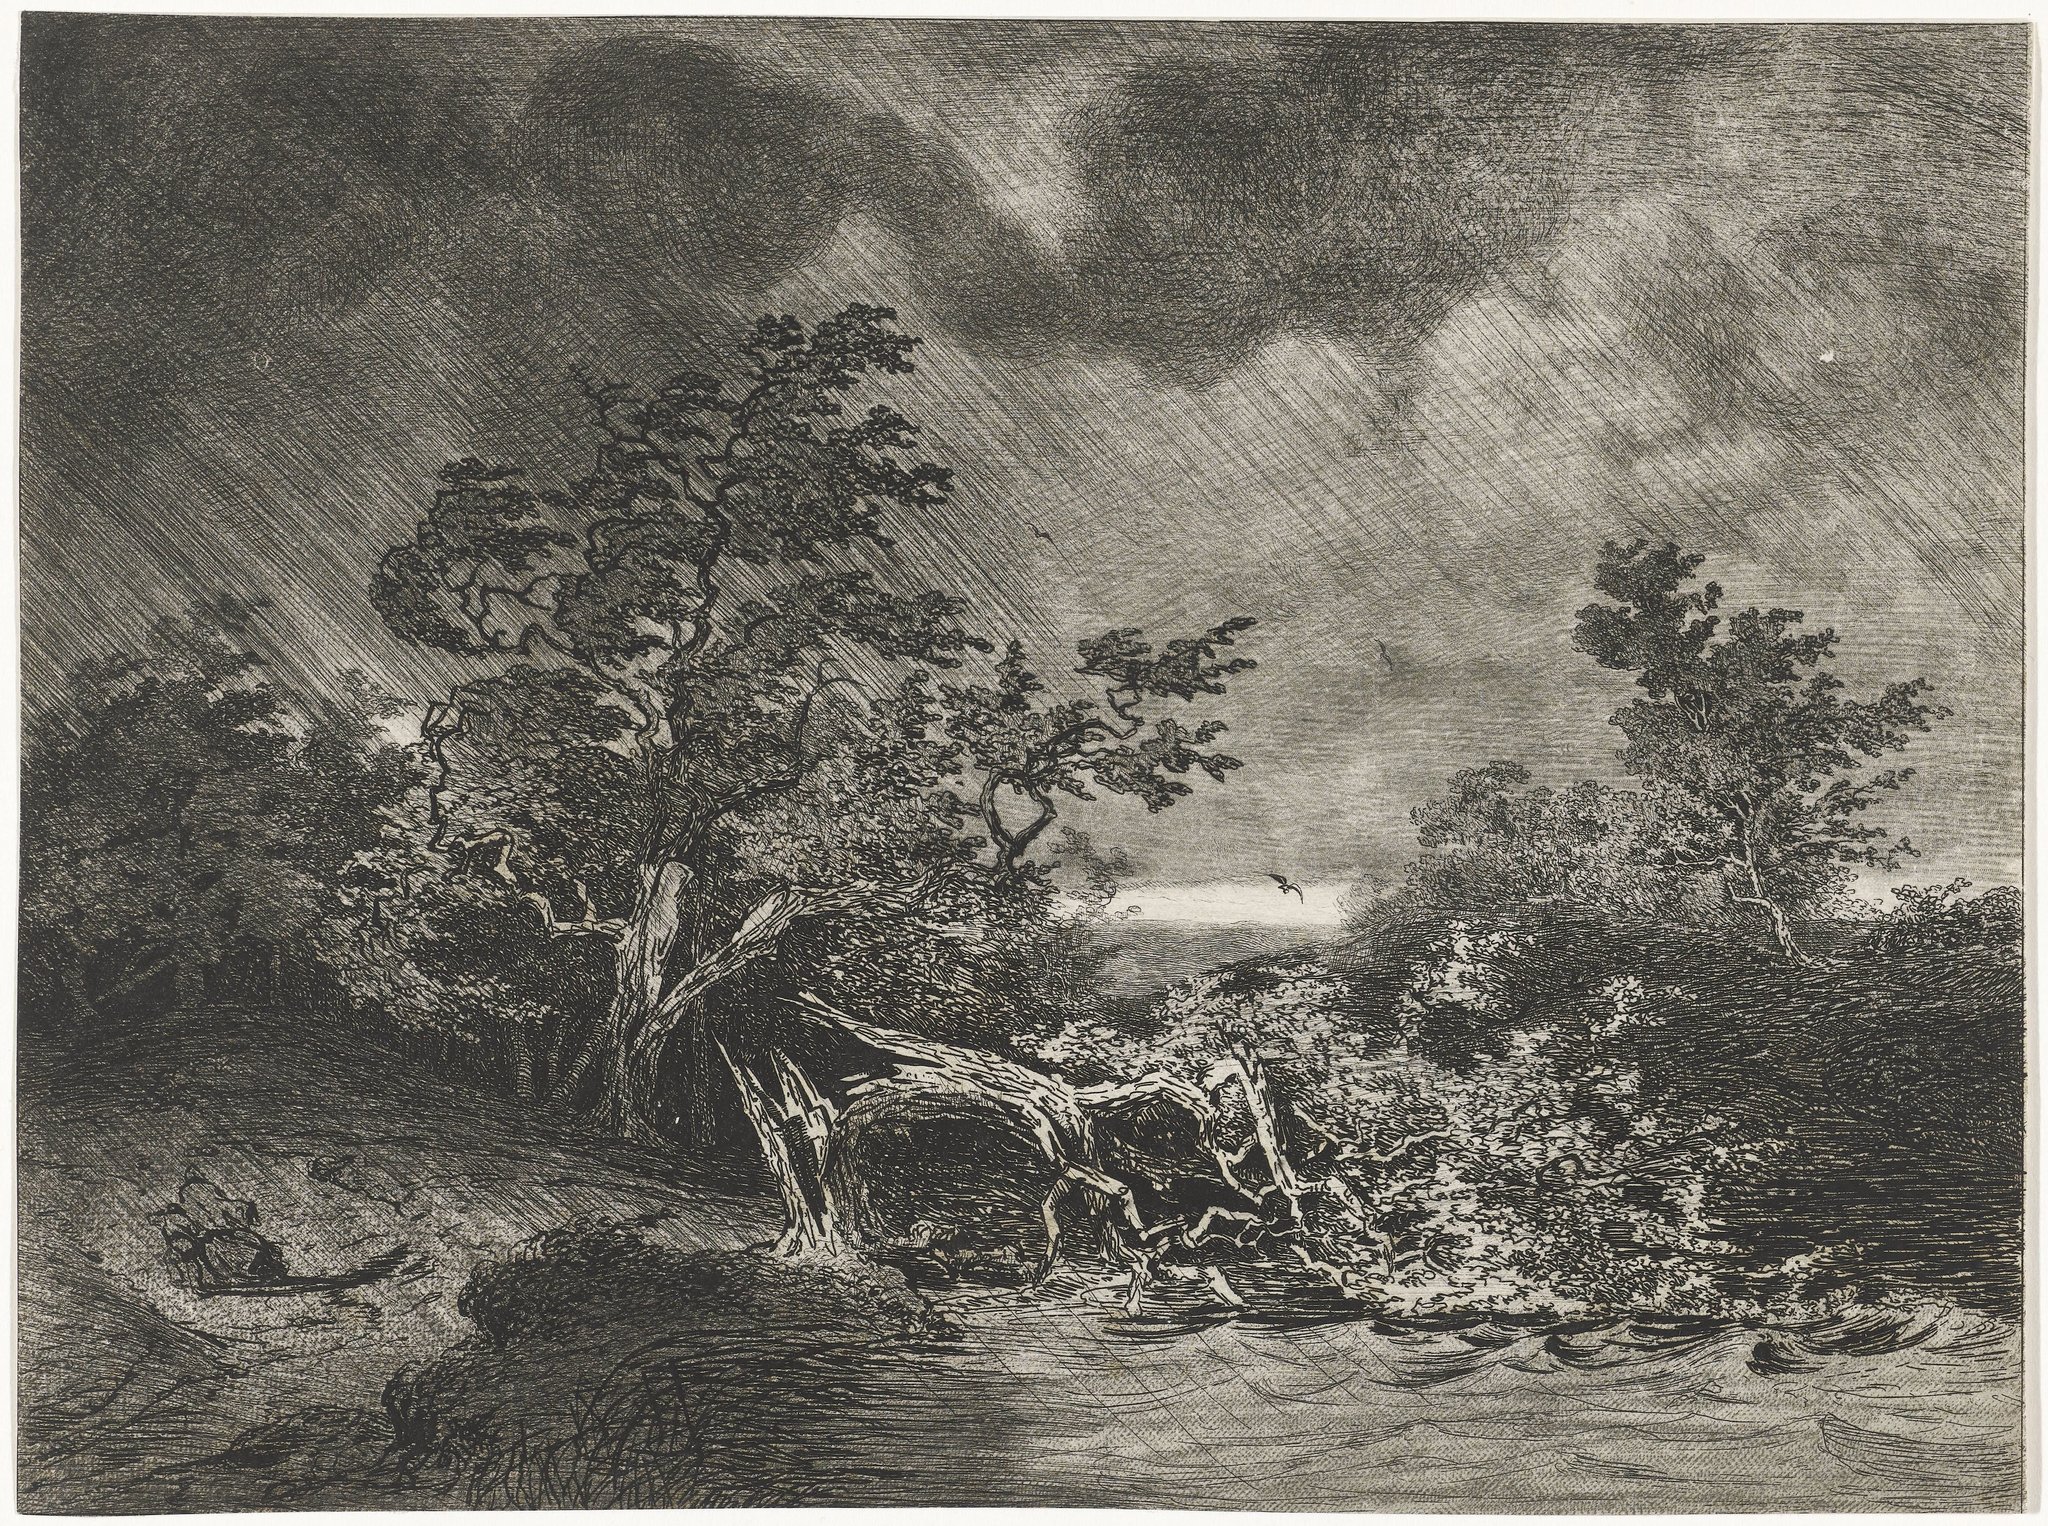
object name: print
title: Storm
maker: martinus antonius kuytenbrouwer jr.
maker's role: draughtsman, painter, print maker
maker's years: 1821-1897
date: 1831-1897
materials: paper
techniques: drypoint, etching, intaglio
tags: trees, pond, storm on land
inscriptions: collector's mark: Lugt 1485, inscription: ‘2e état avec les travary a la roulette’, collector's mark: Lugt 2228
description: Een storm jaagt door een stuk bos met een poel. In het midden is een boom omgewaaid en rechts slaan de golven van het meer tegen het land. Links lopen twee figuren over een bospad, hun kleding wappert in de wind.